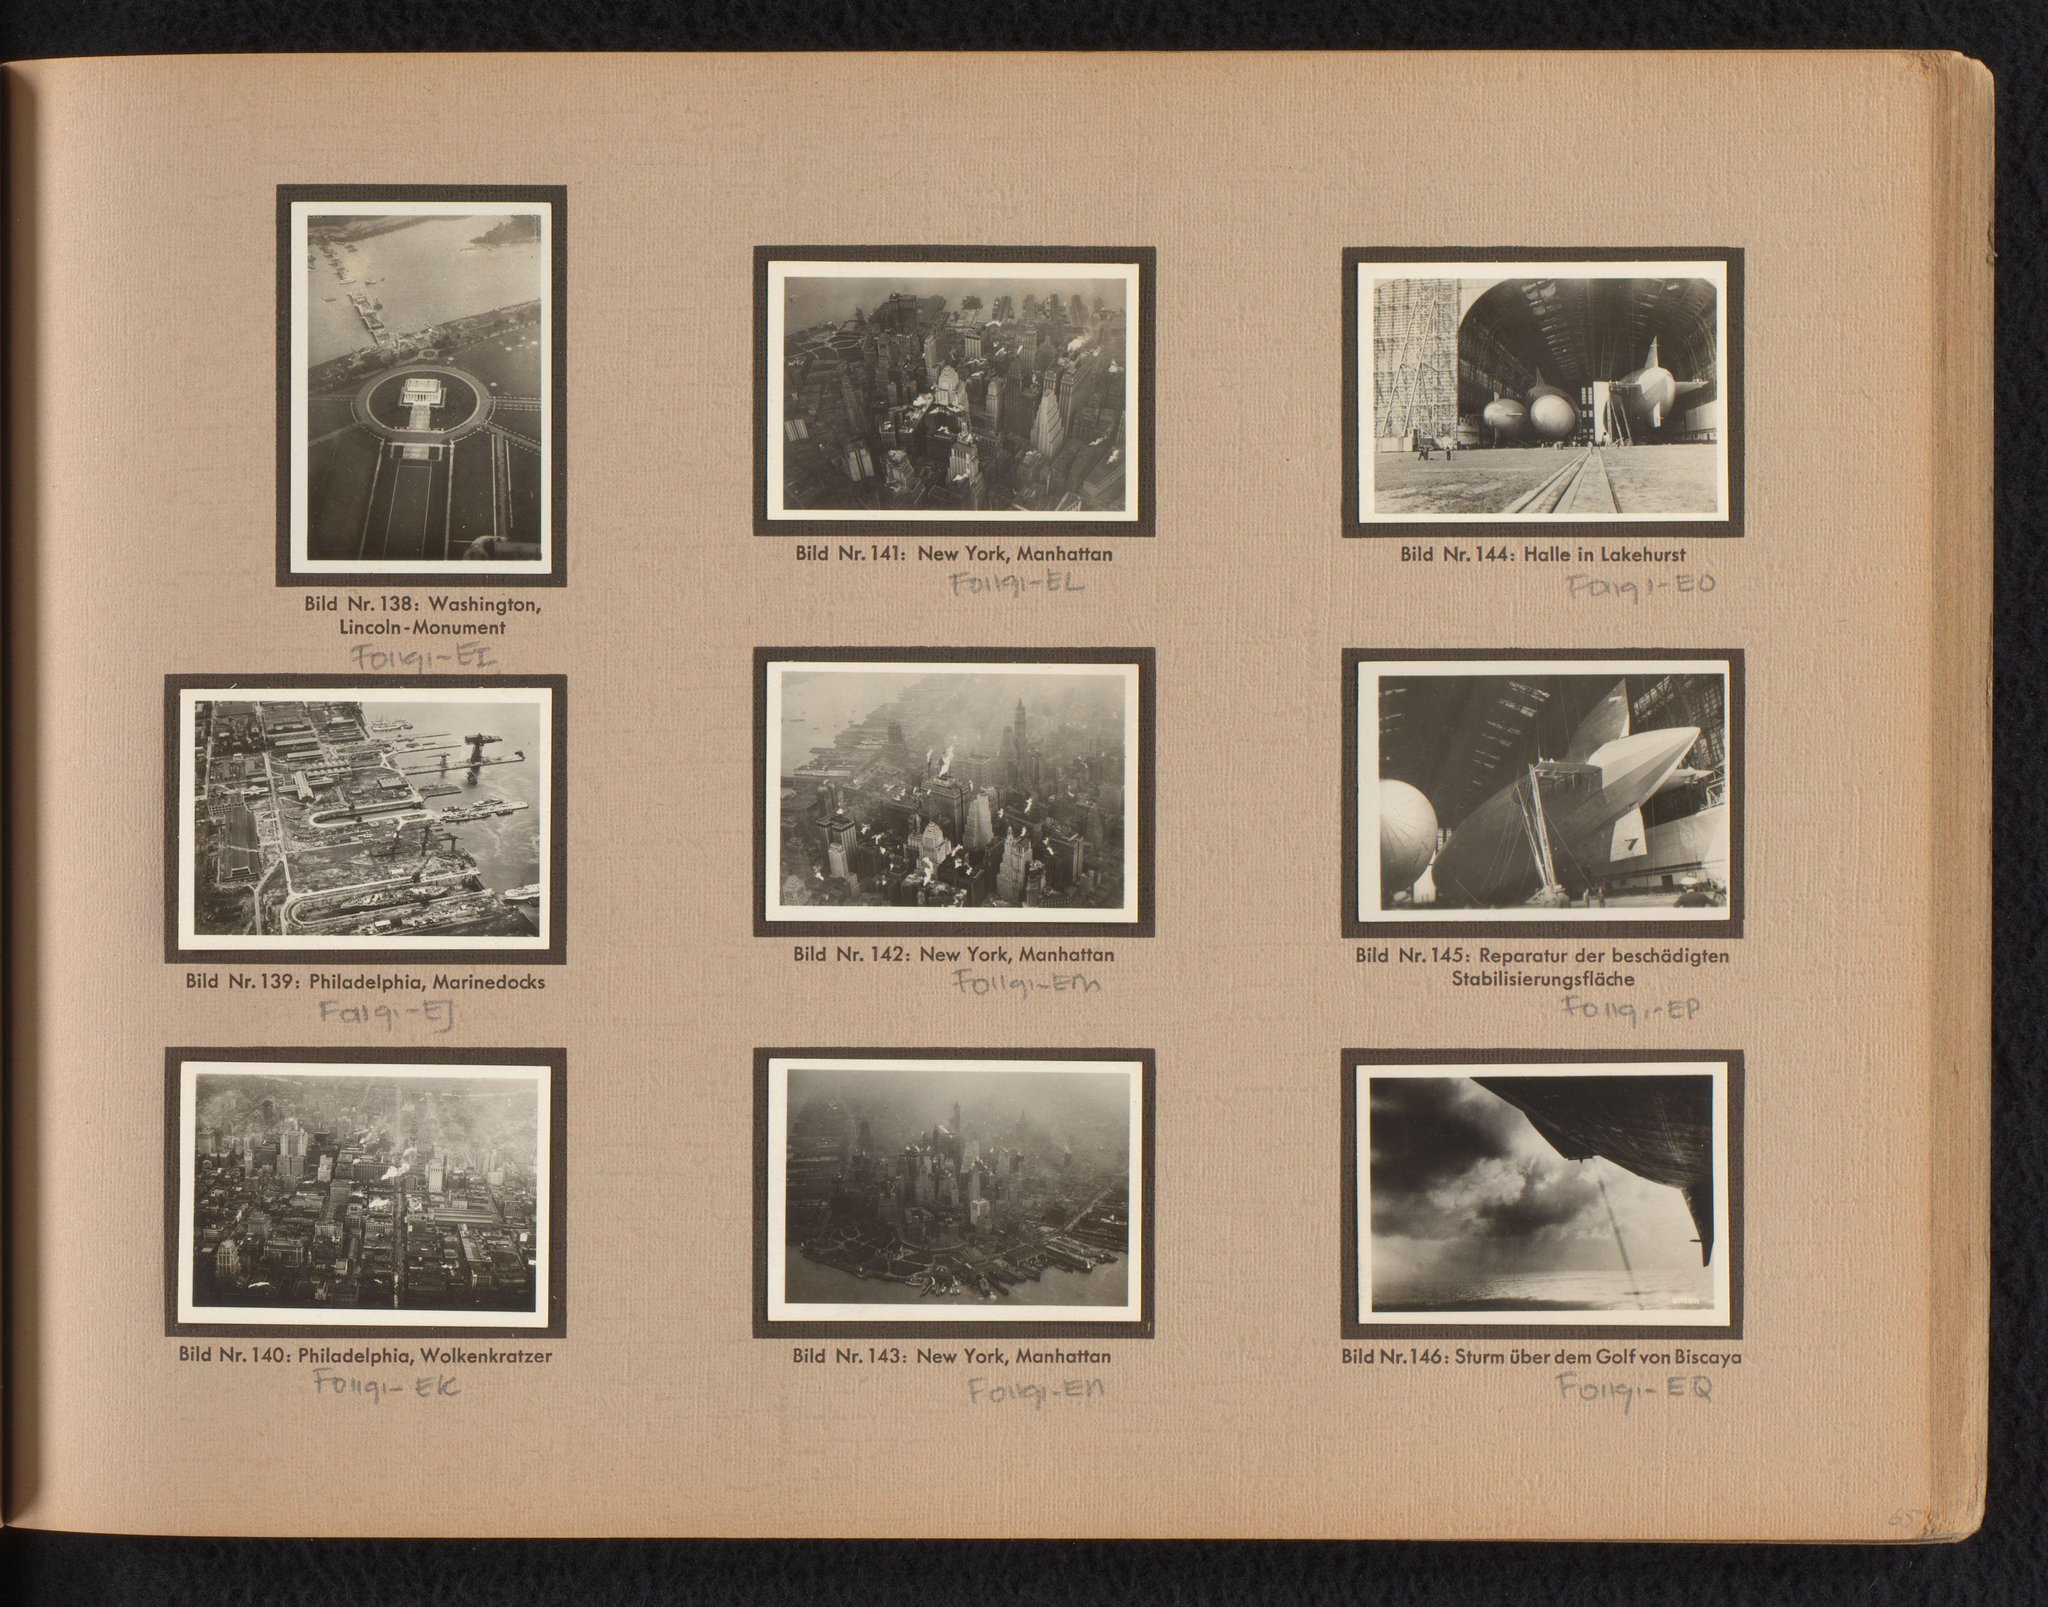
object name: album leaf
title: Uitzichten tijdens een vlucht naar de Verenigde Staten van Amerika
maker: Anonymous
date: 1924-1928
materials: paper, photographic support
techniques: gelatin silver print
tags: city-view, and landscape with man-made constructions, 46c35 airship, zeppelin, new york (city)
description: Negen foto's gemaakt tijdens vluchten naar Verenigde Staten van Amerika, waaronder gezichten op Washington, Philadelphia en New York. Alle foto's zijn voorzien van een nummer en titel. Deze pagina maakt deel uit van een album.